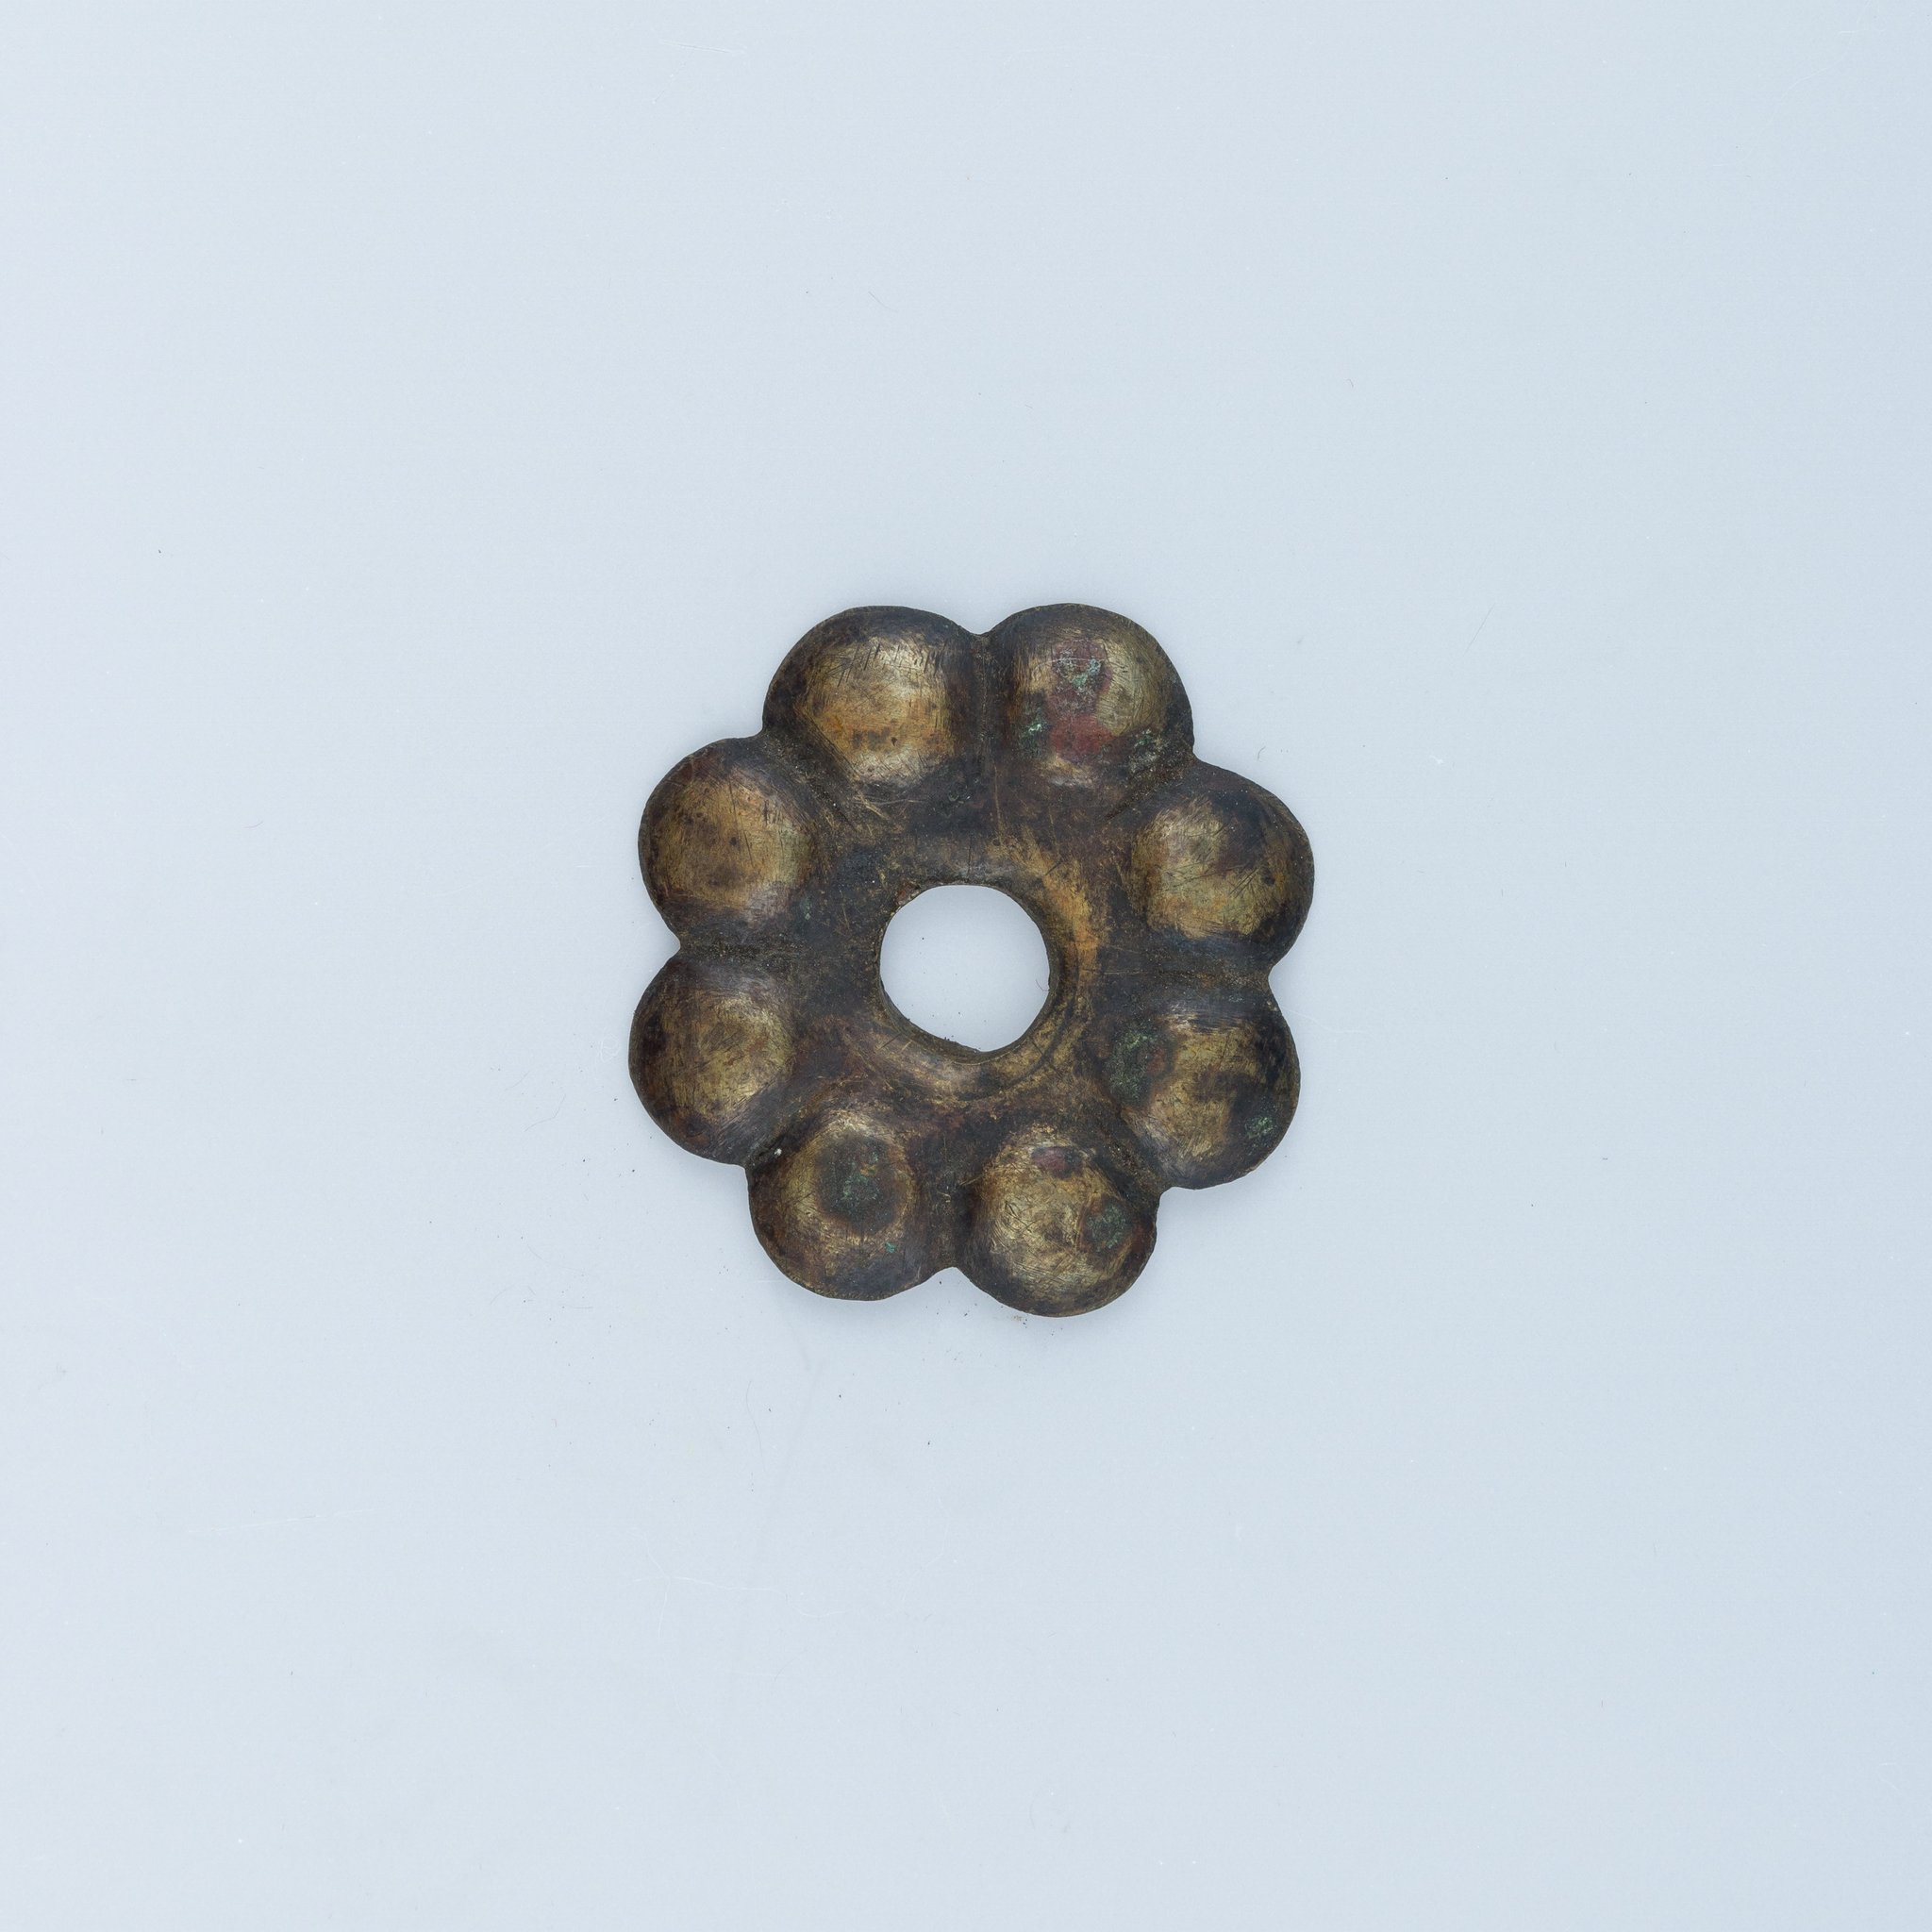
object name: rosette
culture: italian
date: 1540-1560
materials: brass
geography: italy